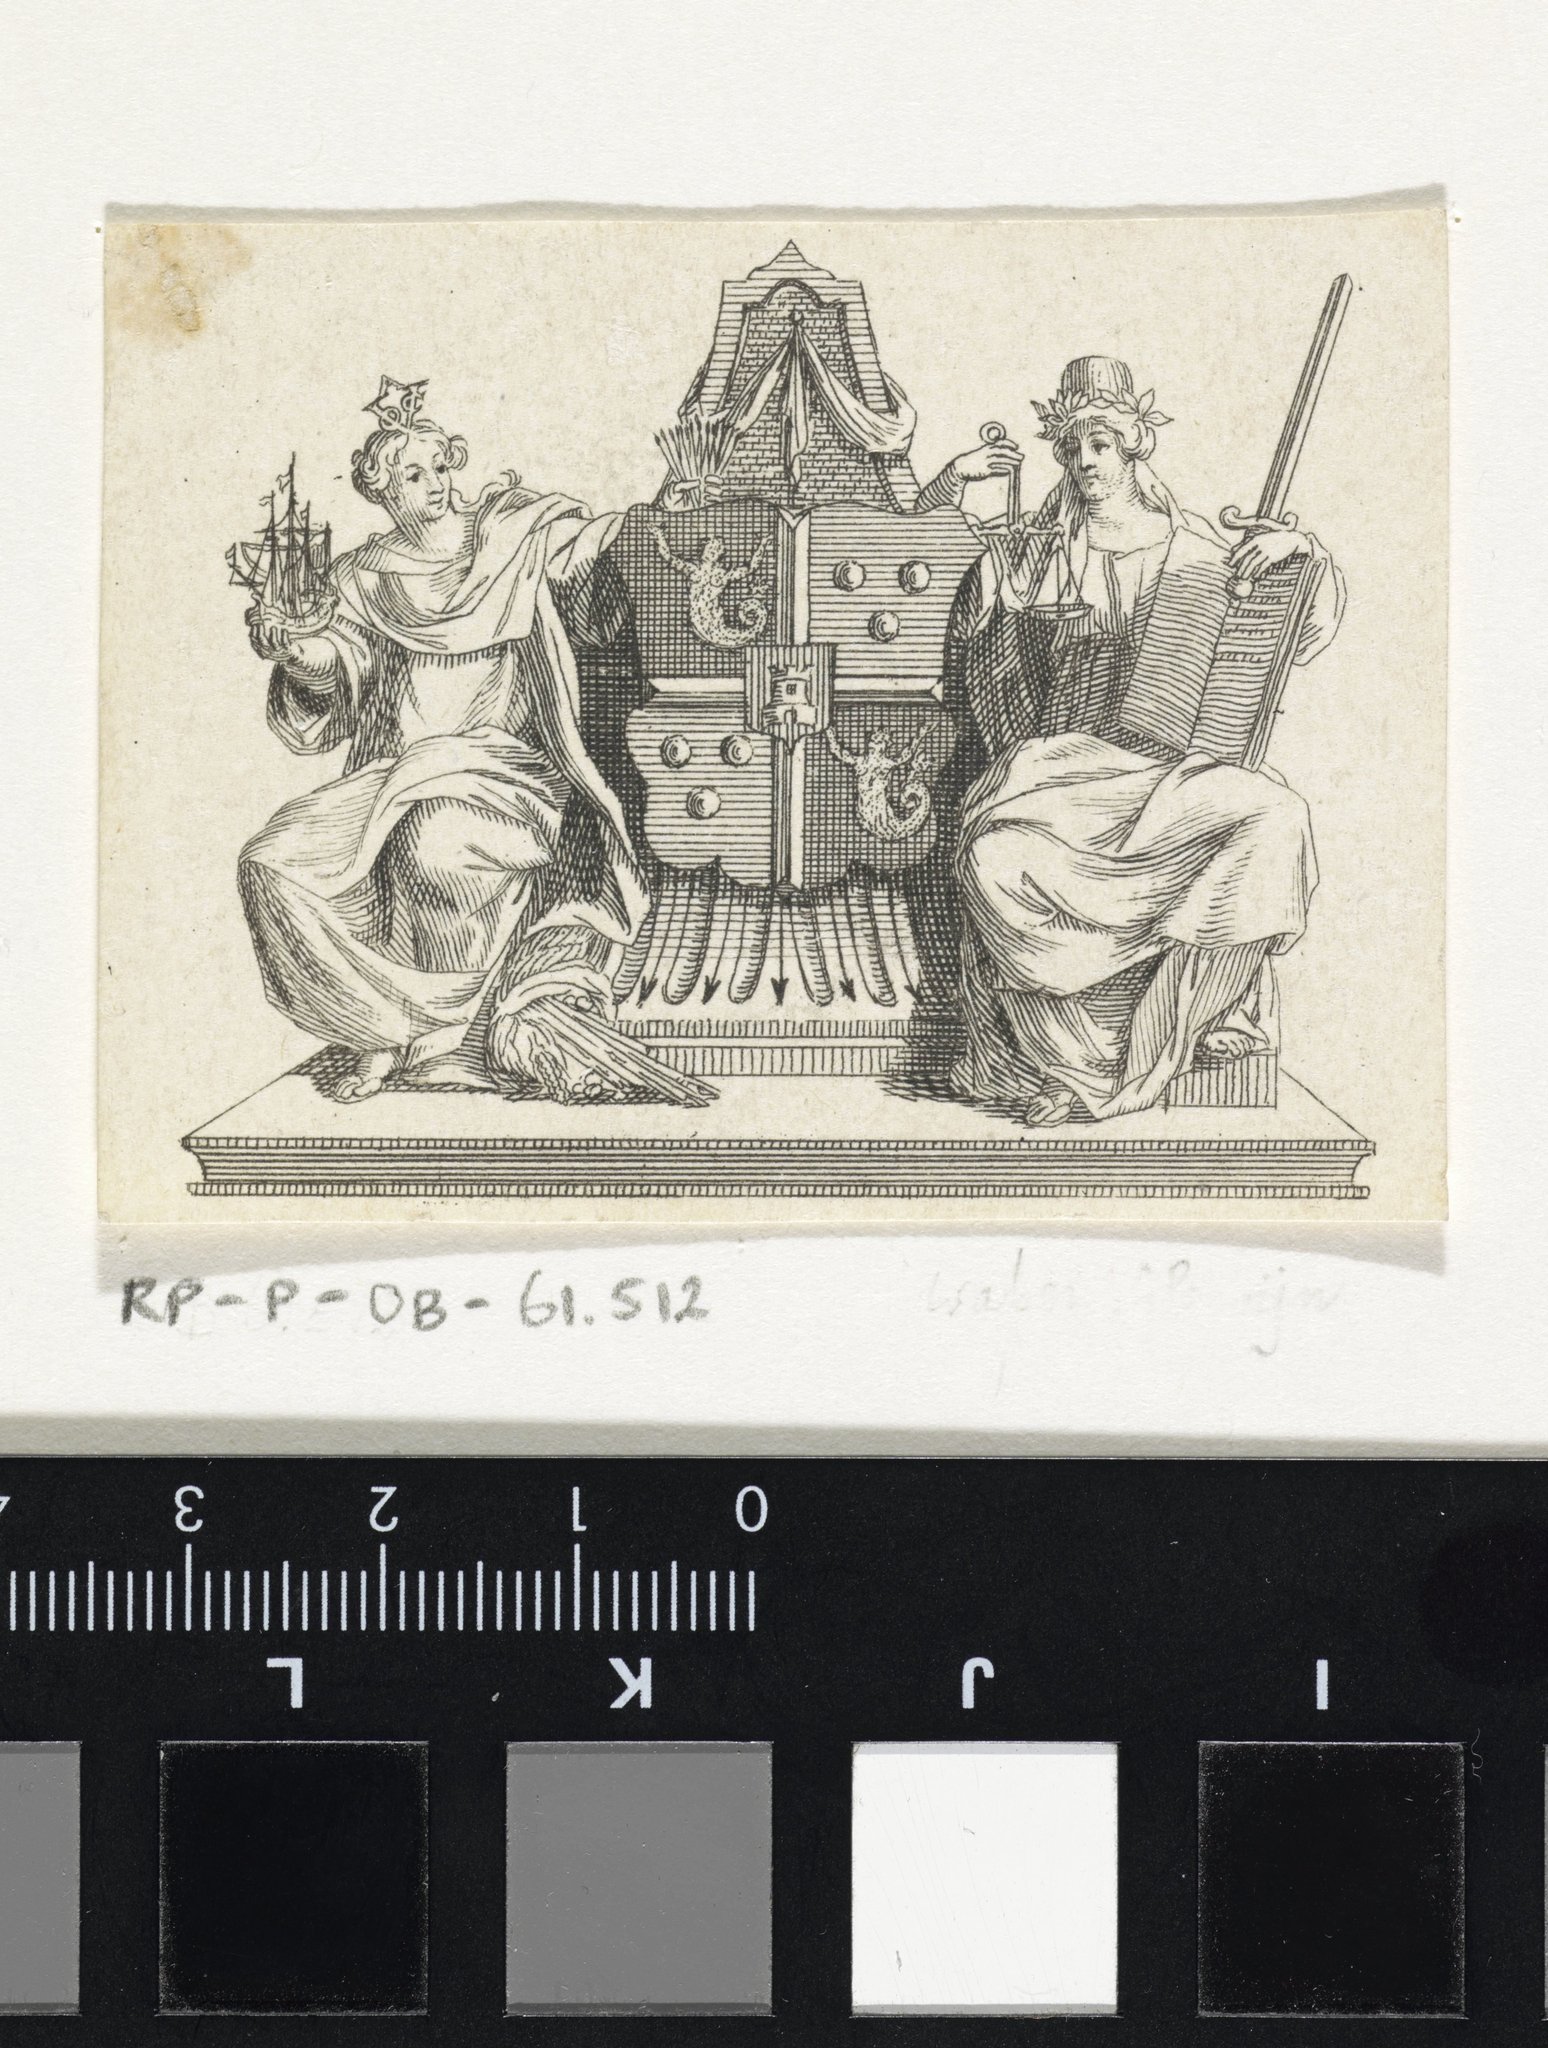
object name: print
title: Vignet met het wapen van familie Alewijn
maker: jan wandelaar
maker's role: draughtsman, print maker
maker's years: 1690-1759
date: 1710-1759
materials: paper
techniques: etching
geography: northern netherlands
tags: justice, 'justitia'; 'giustitia divina' (ripa) ~ one of the four cardinal virtues, merman - aa - mermaid, siren, armorial bearing, heraldry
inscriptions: collector's mark: Lugt 240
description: Het wapen is mogelijk vervaardigd tijdens het leven van Dirk Alewijn (1719-1757), die de buitenplaats 'De Meermin' in de Beemster verkreeg en vanaf 1756 bewindhebber van de Kamer van de VOC te Amsterdam was.